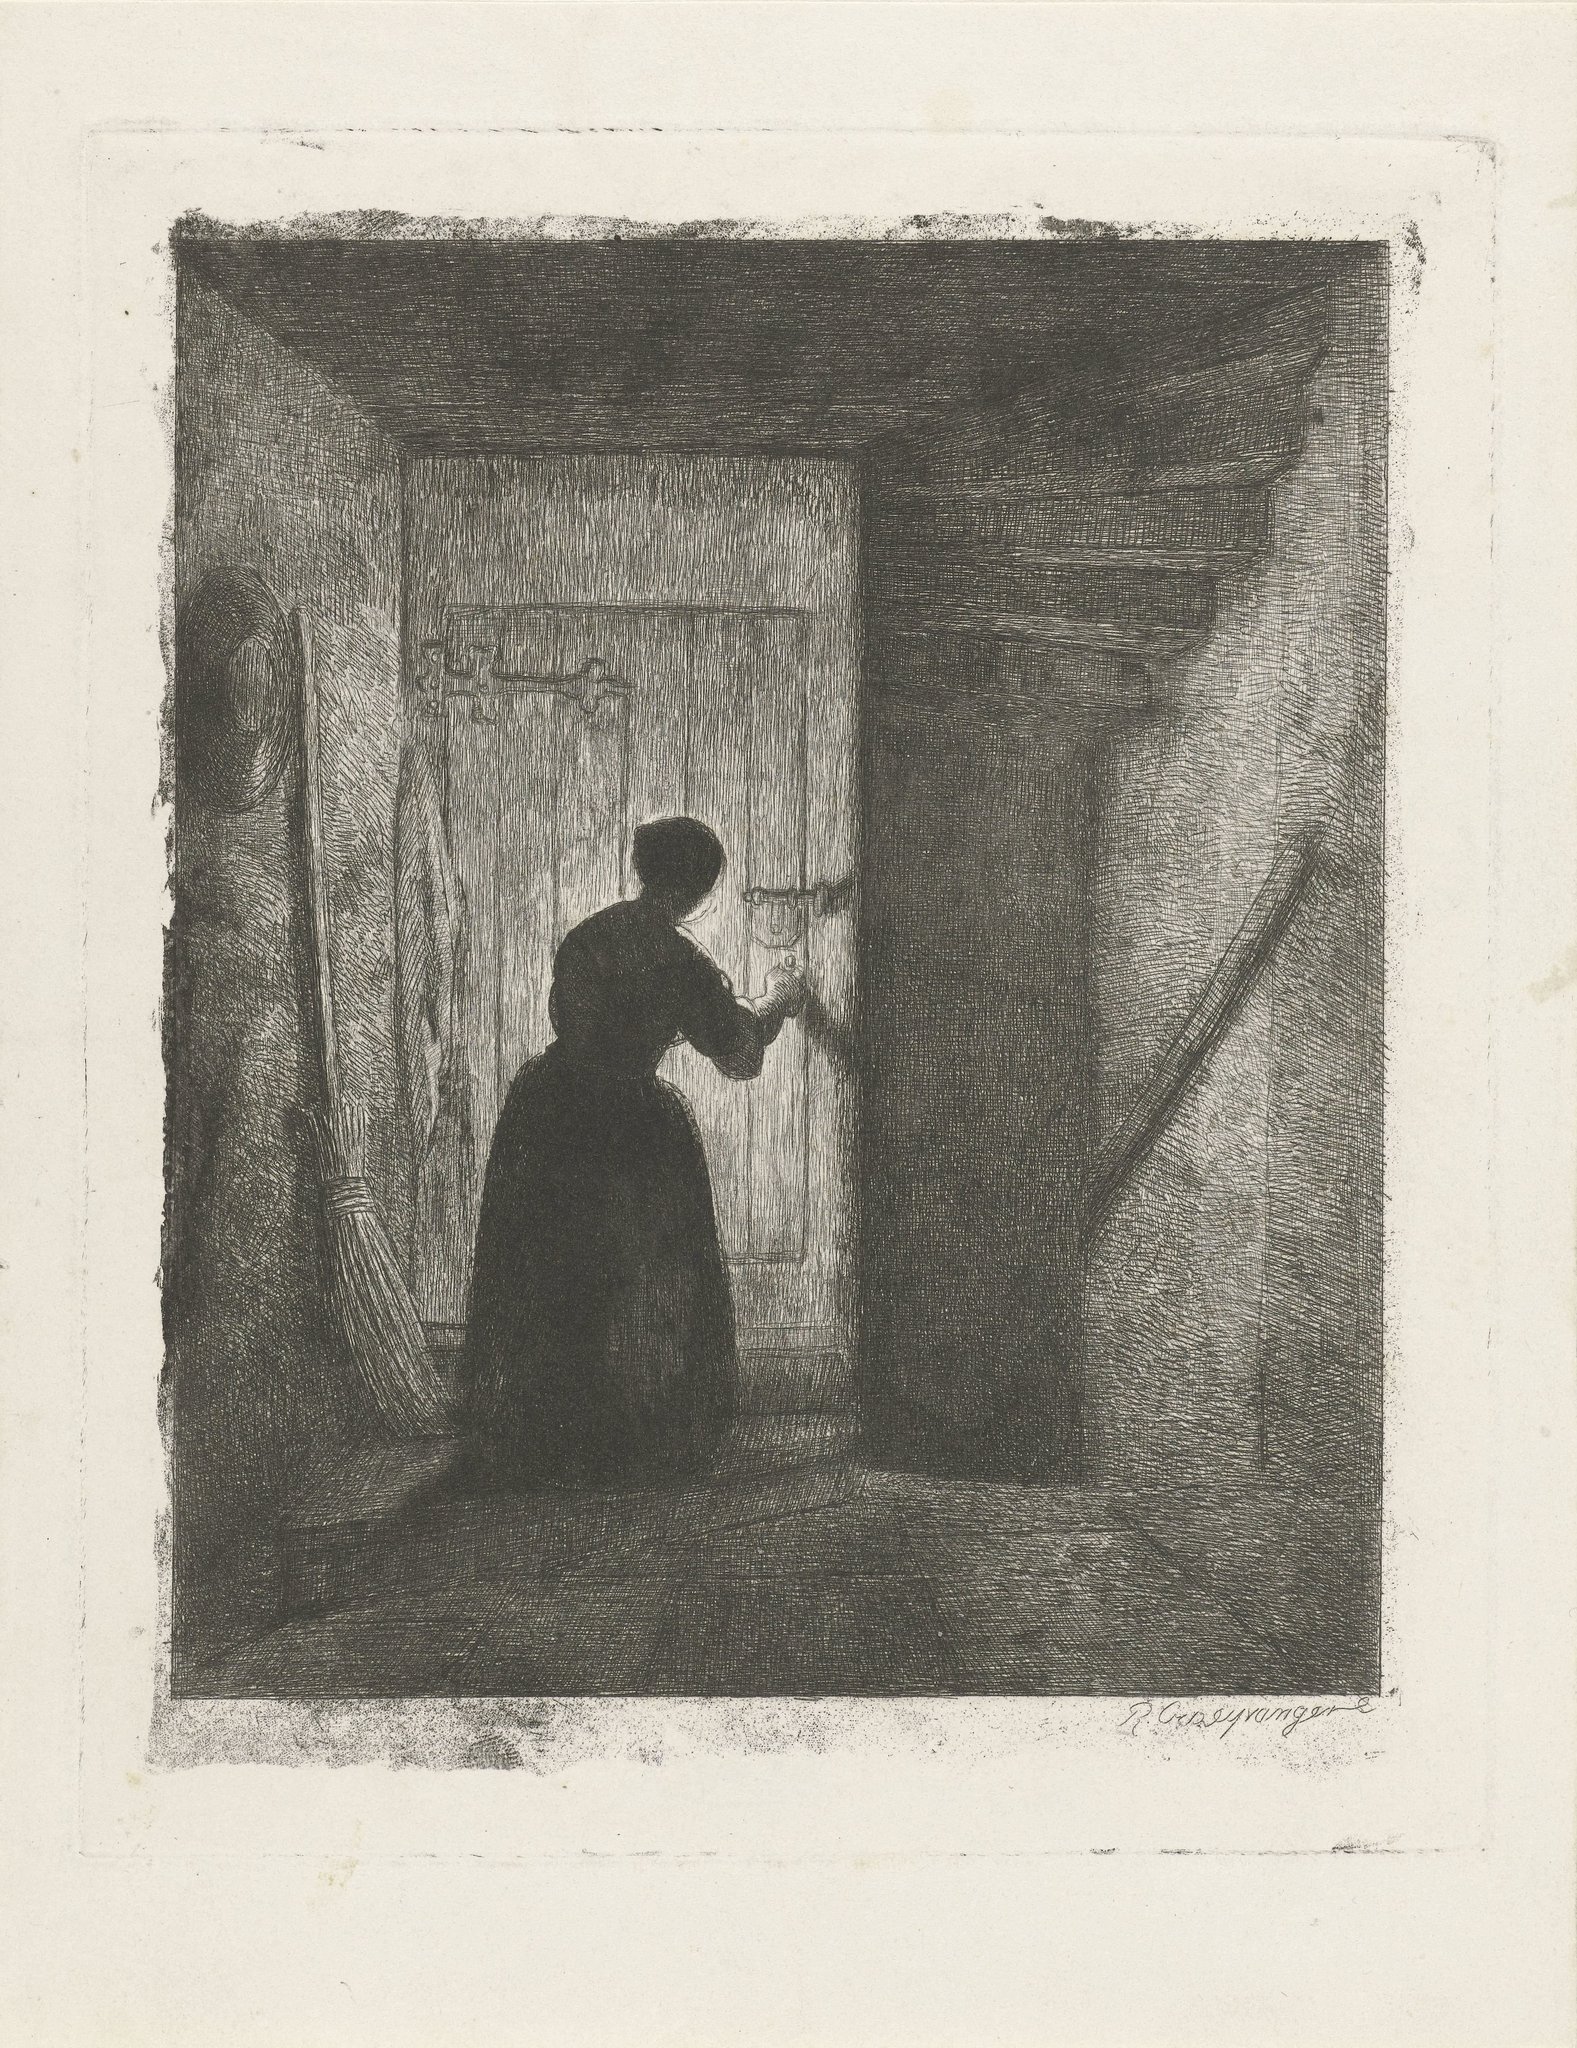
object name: print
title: Vrouw voor een deur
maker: reinier craeyvanger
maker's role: draughtsman, print maker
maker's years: 1812-1880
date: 1822-1880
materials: paper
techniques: etching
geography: amsterdam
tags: adult woman, opening the door, shrubs: broom, closed door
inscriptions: collector's mark: Lugt 2228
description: Een vrouw staat voor een deur en draait aan de sleutel. Rechts een trap naar beneden. Links staat een veger tegen de muur. Een hoed en een jas hangen aan de muur.